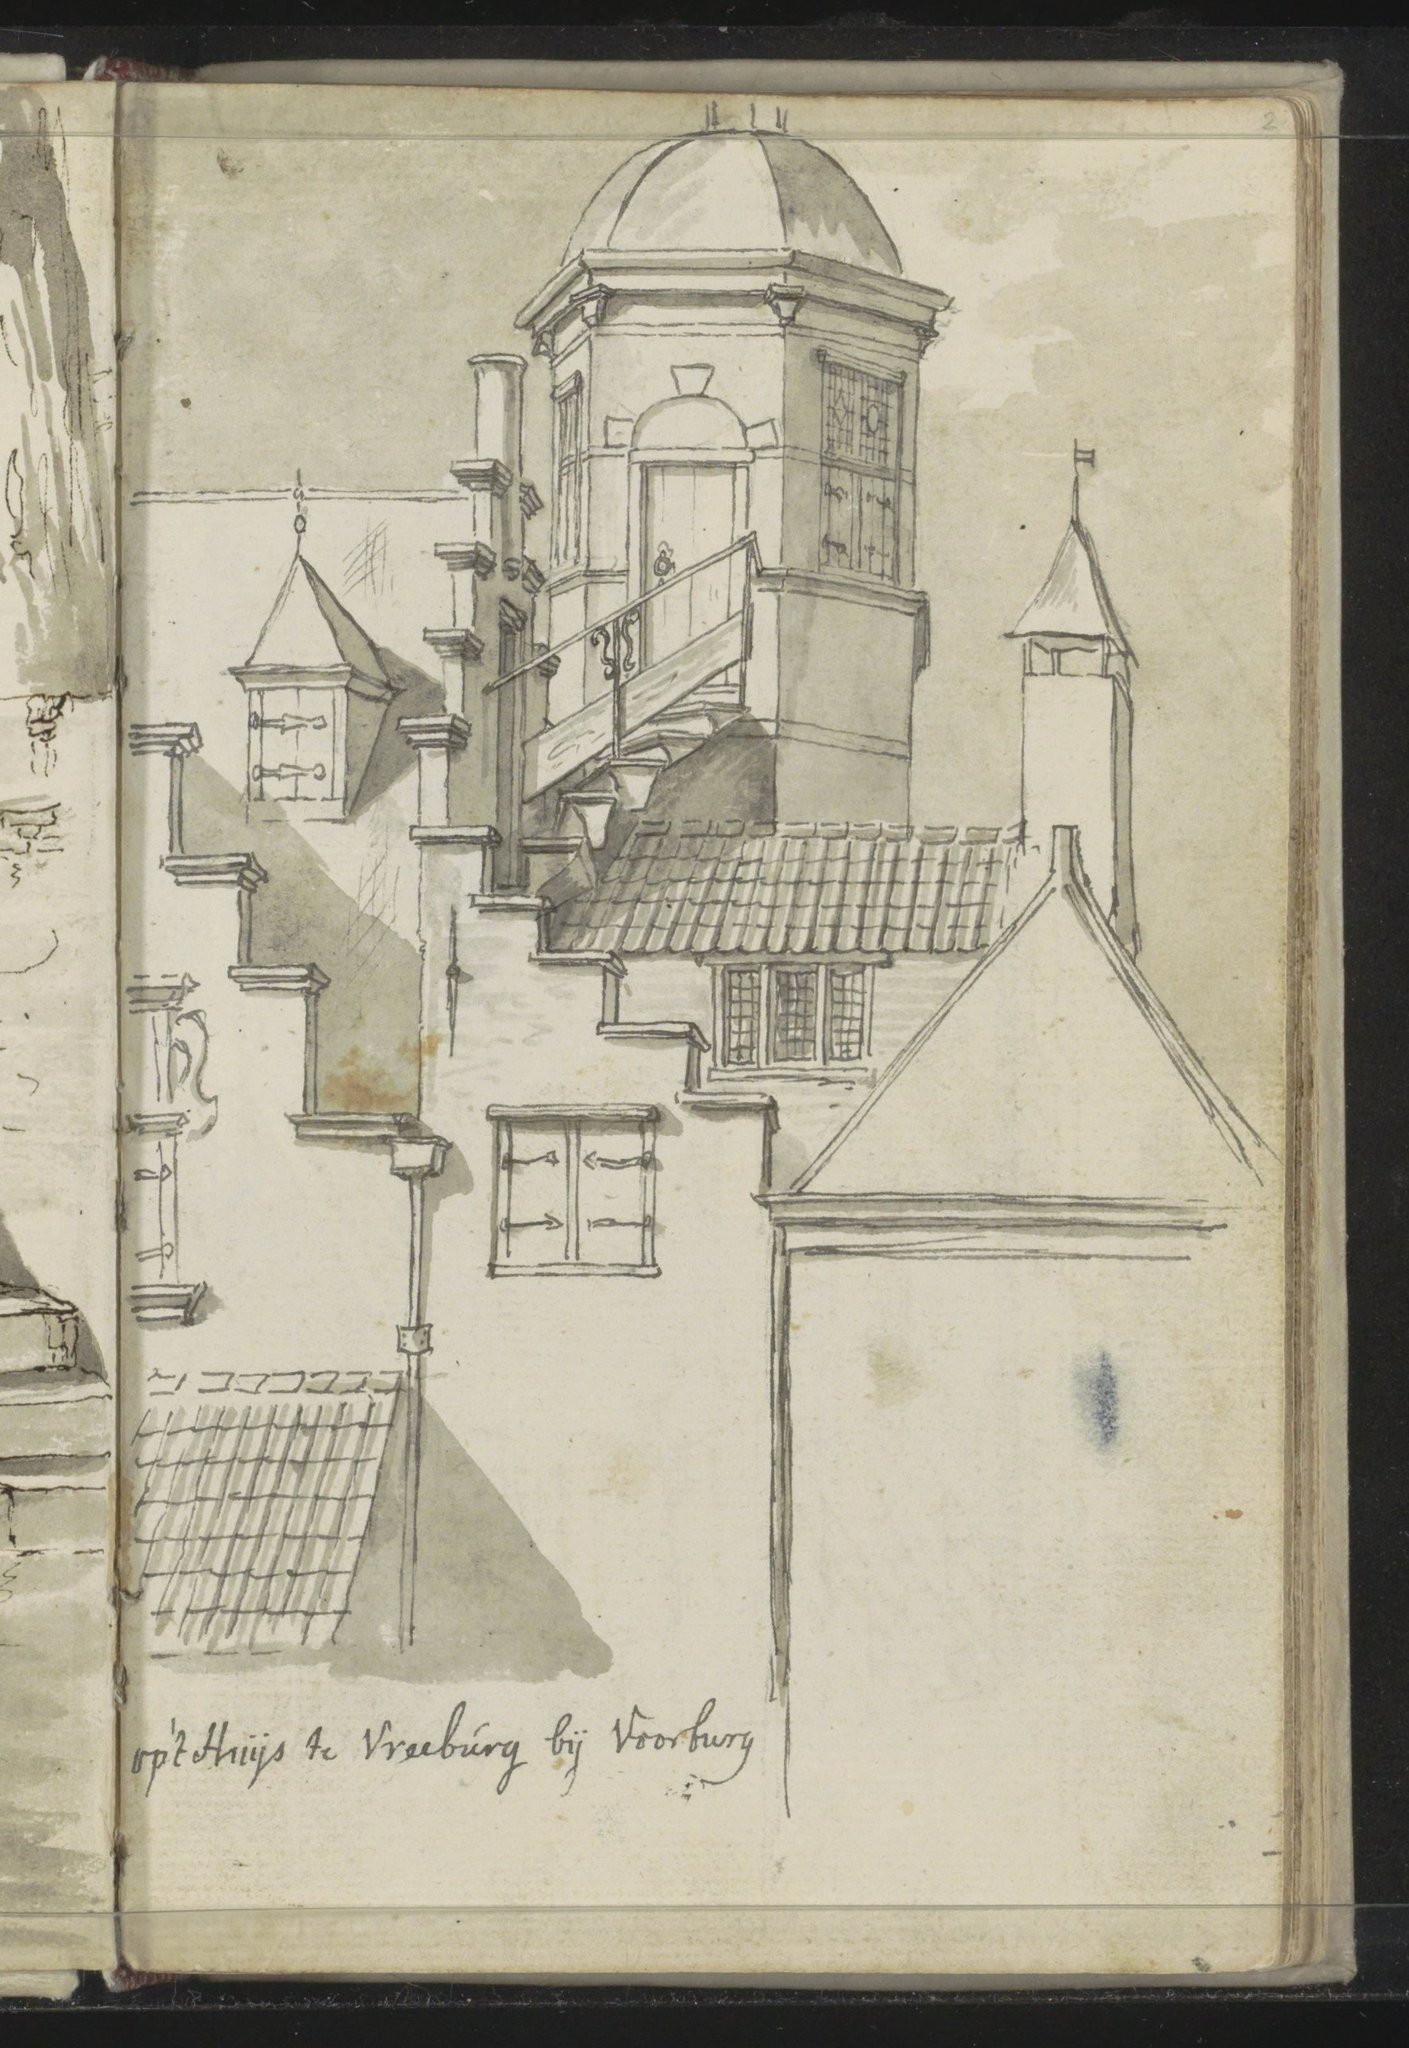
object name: sketchbook leaf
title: Gezicht op Huis Vreeburg bij Voorburg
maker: johannes huibert prins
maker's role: draughtsman, painter, print maker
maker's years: 1757-1806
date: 1783-1797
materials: ink, paper, pencil, watercolor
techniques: brush, pen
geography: voorburg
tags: country-house, voorburg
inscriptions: annotation: ‘op 't Huijs te Vreeburg bij Voorburg’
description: Pagina 2 uit een schetsboek met 175 pagina's.